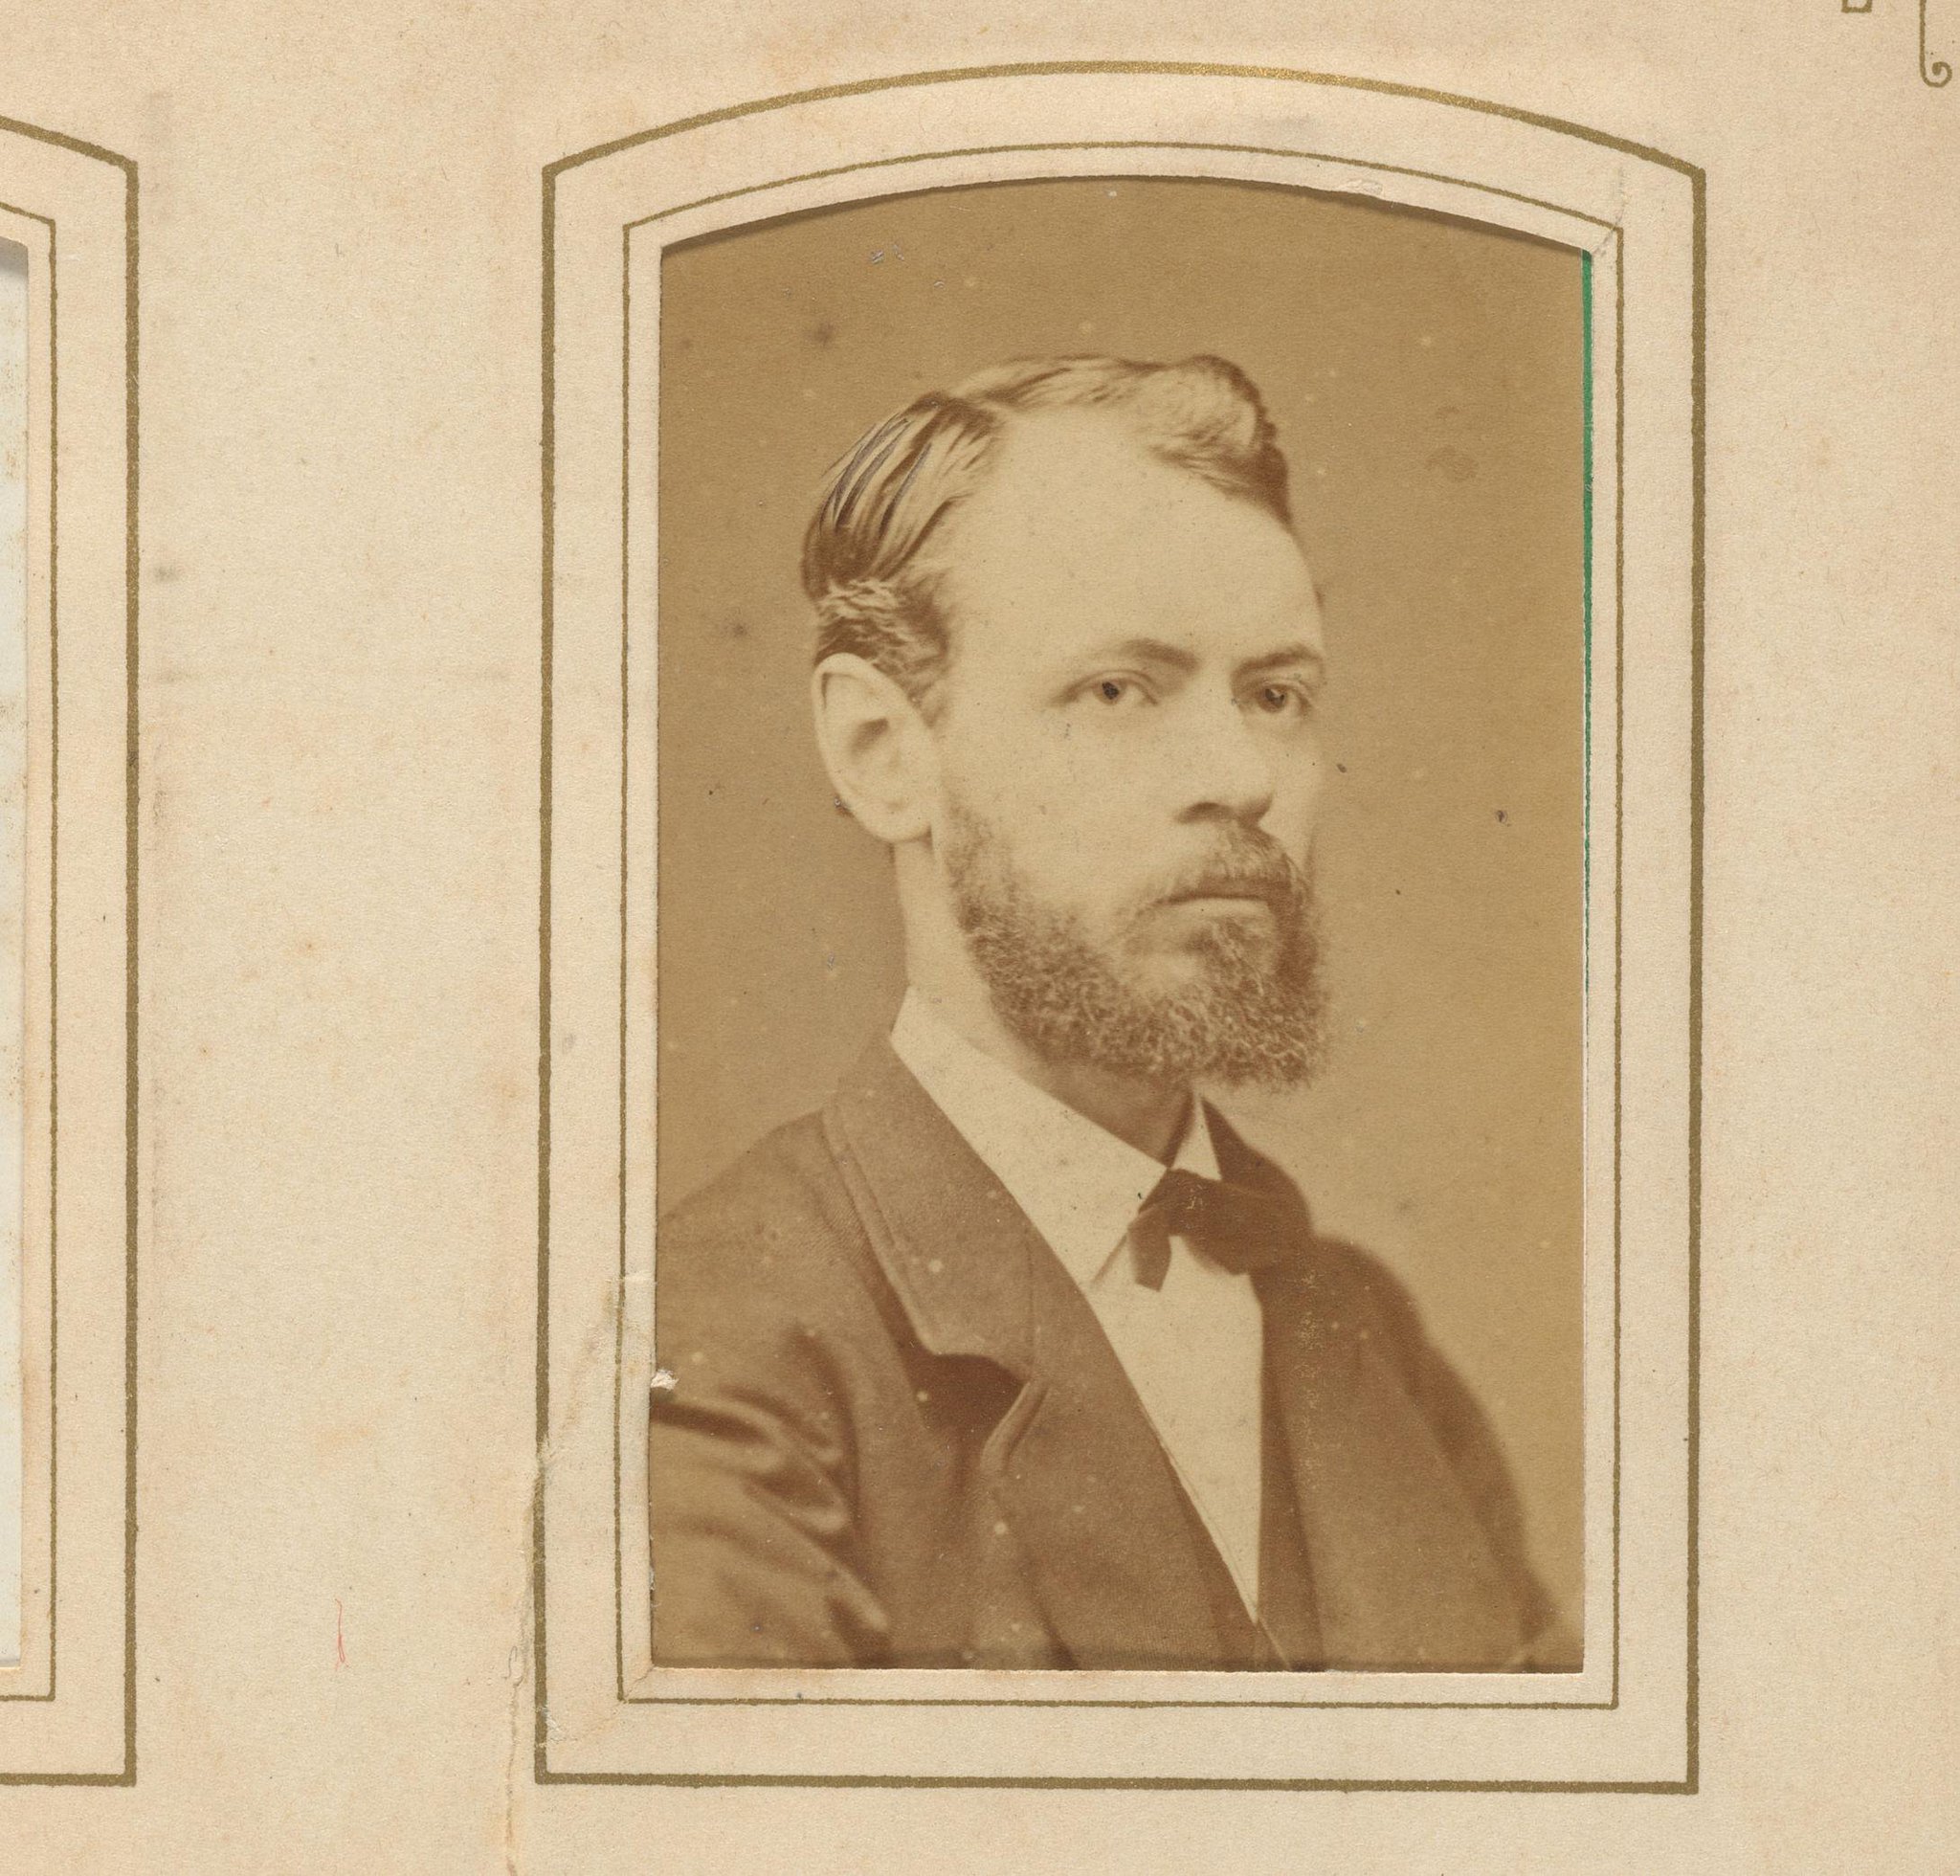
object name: album leaf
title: Portret van een man met snor en baard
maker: Anonymous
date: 1850-1900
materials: cardboard, photographic support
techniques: albumen print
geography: netherlands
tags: moustache, historical persons, beard